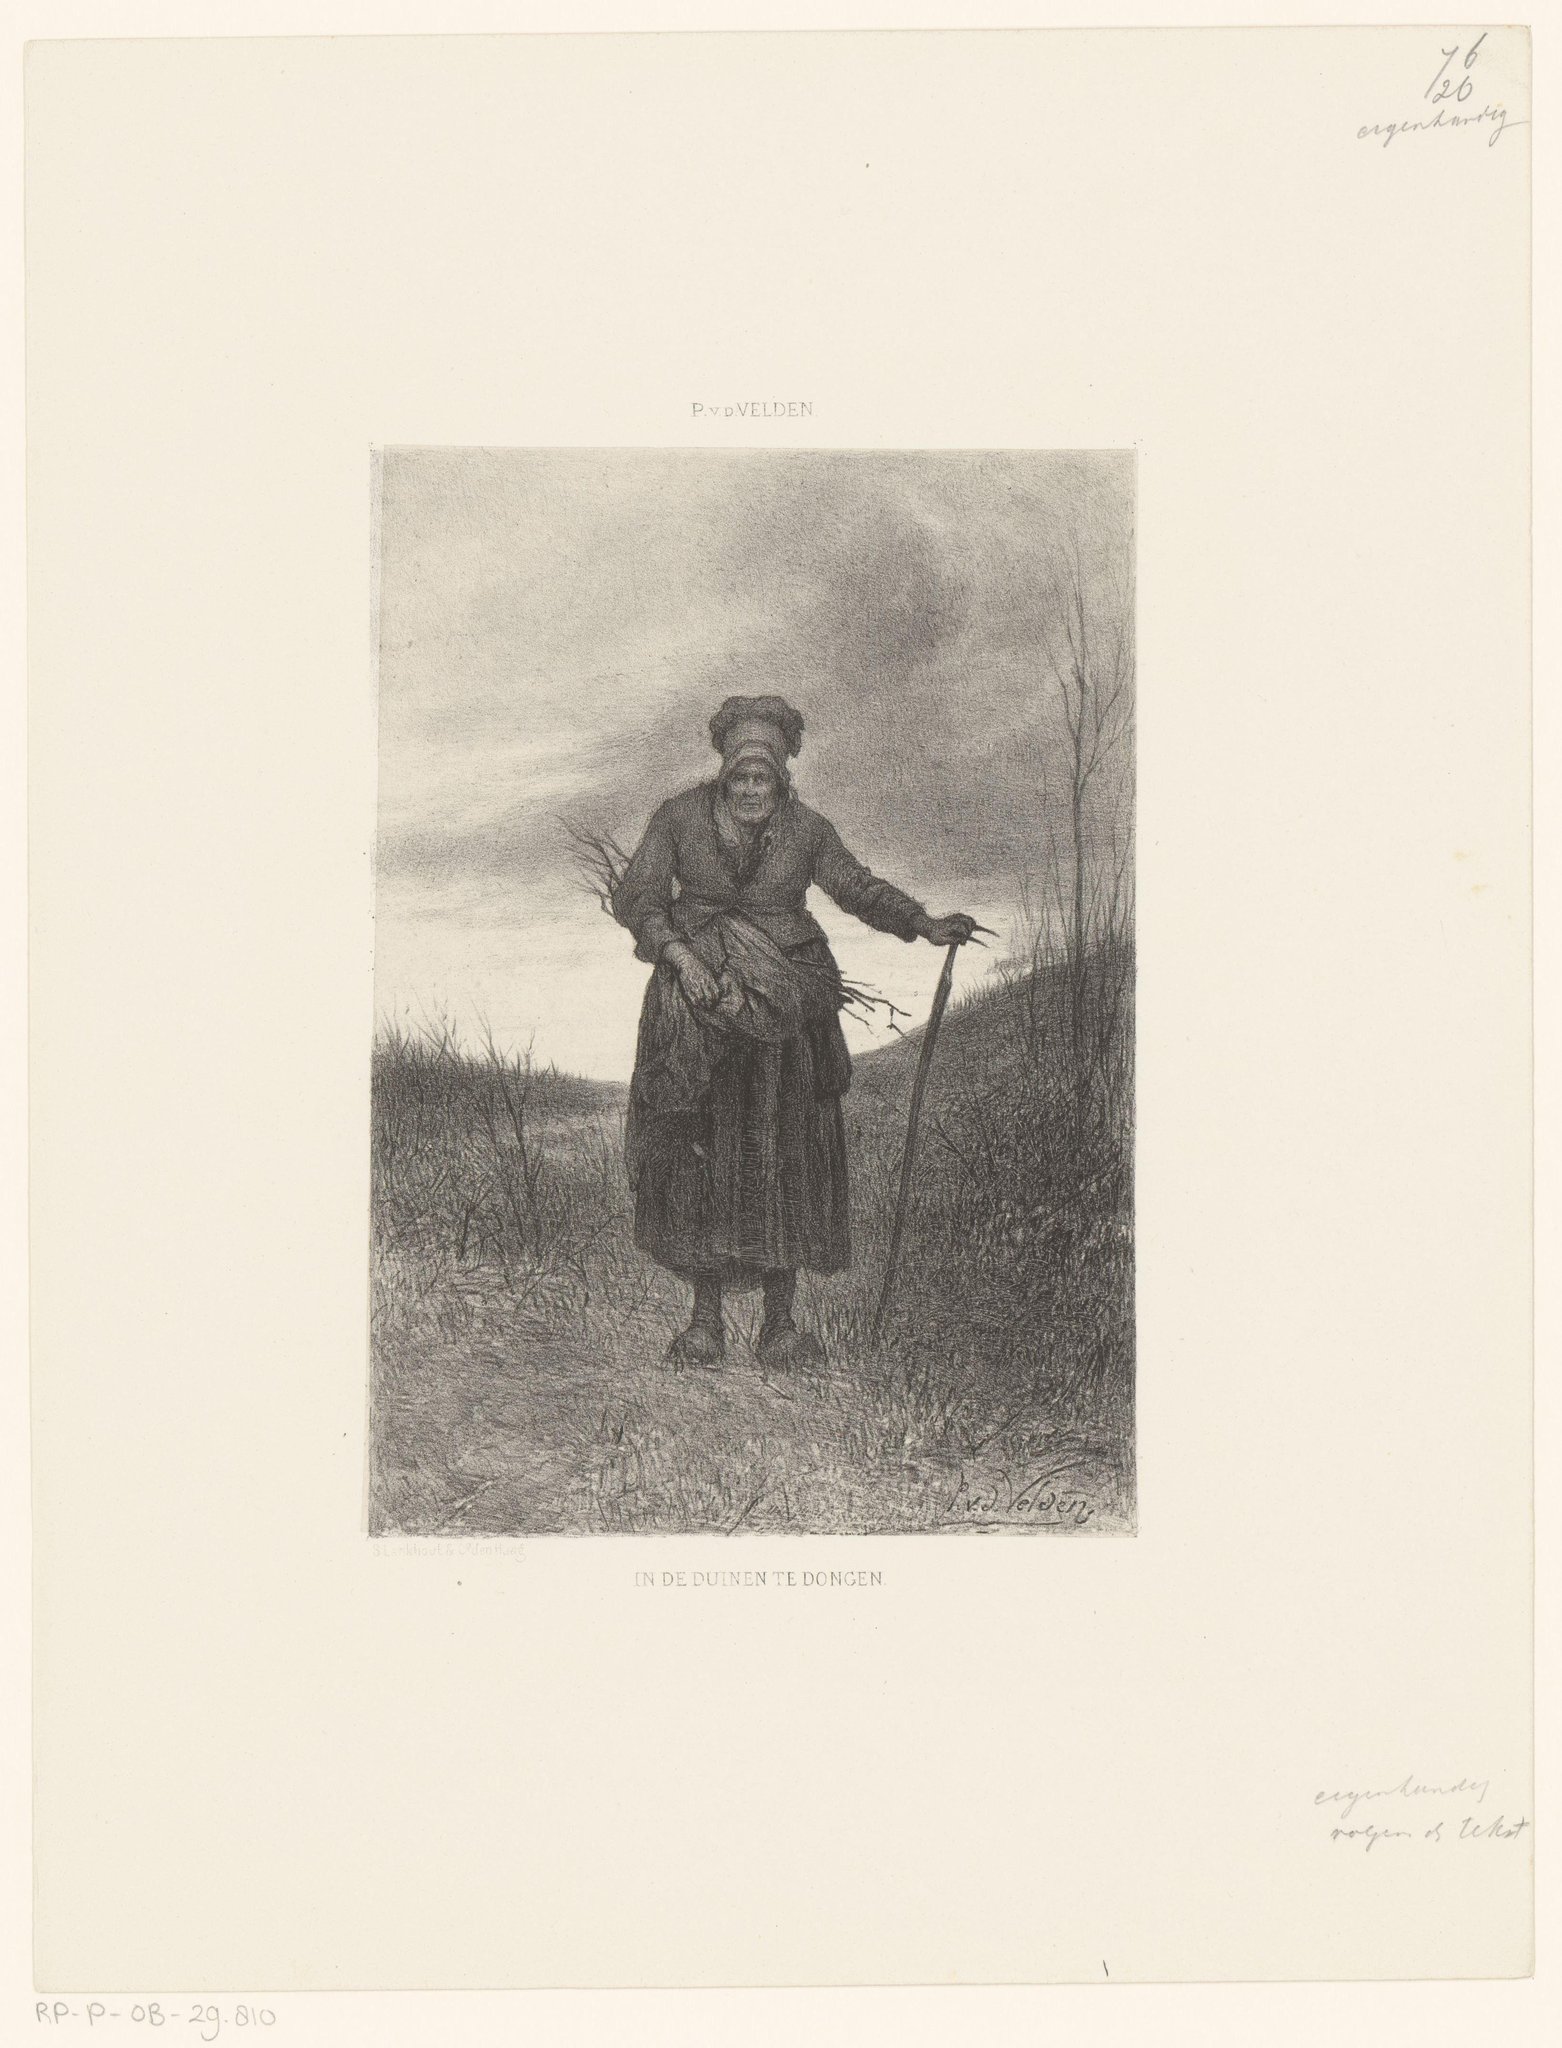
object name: print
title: Oude vrouw met takkenbos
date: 1877-1903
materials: paper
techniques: lithograph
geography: the hague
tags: woodgathering, woodgatherer, old woman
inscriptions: collector's mark: Lugt 2228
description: Een oude vrouw met takkenbos, leunend op haar stok in de duinen te Dongen.